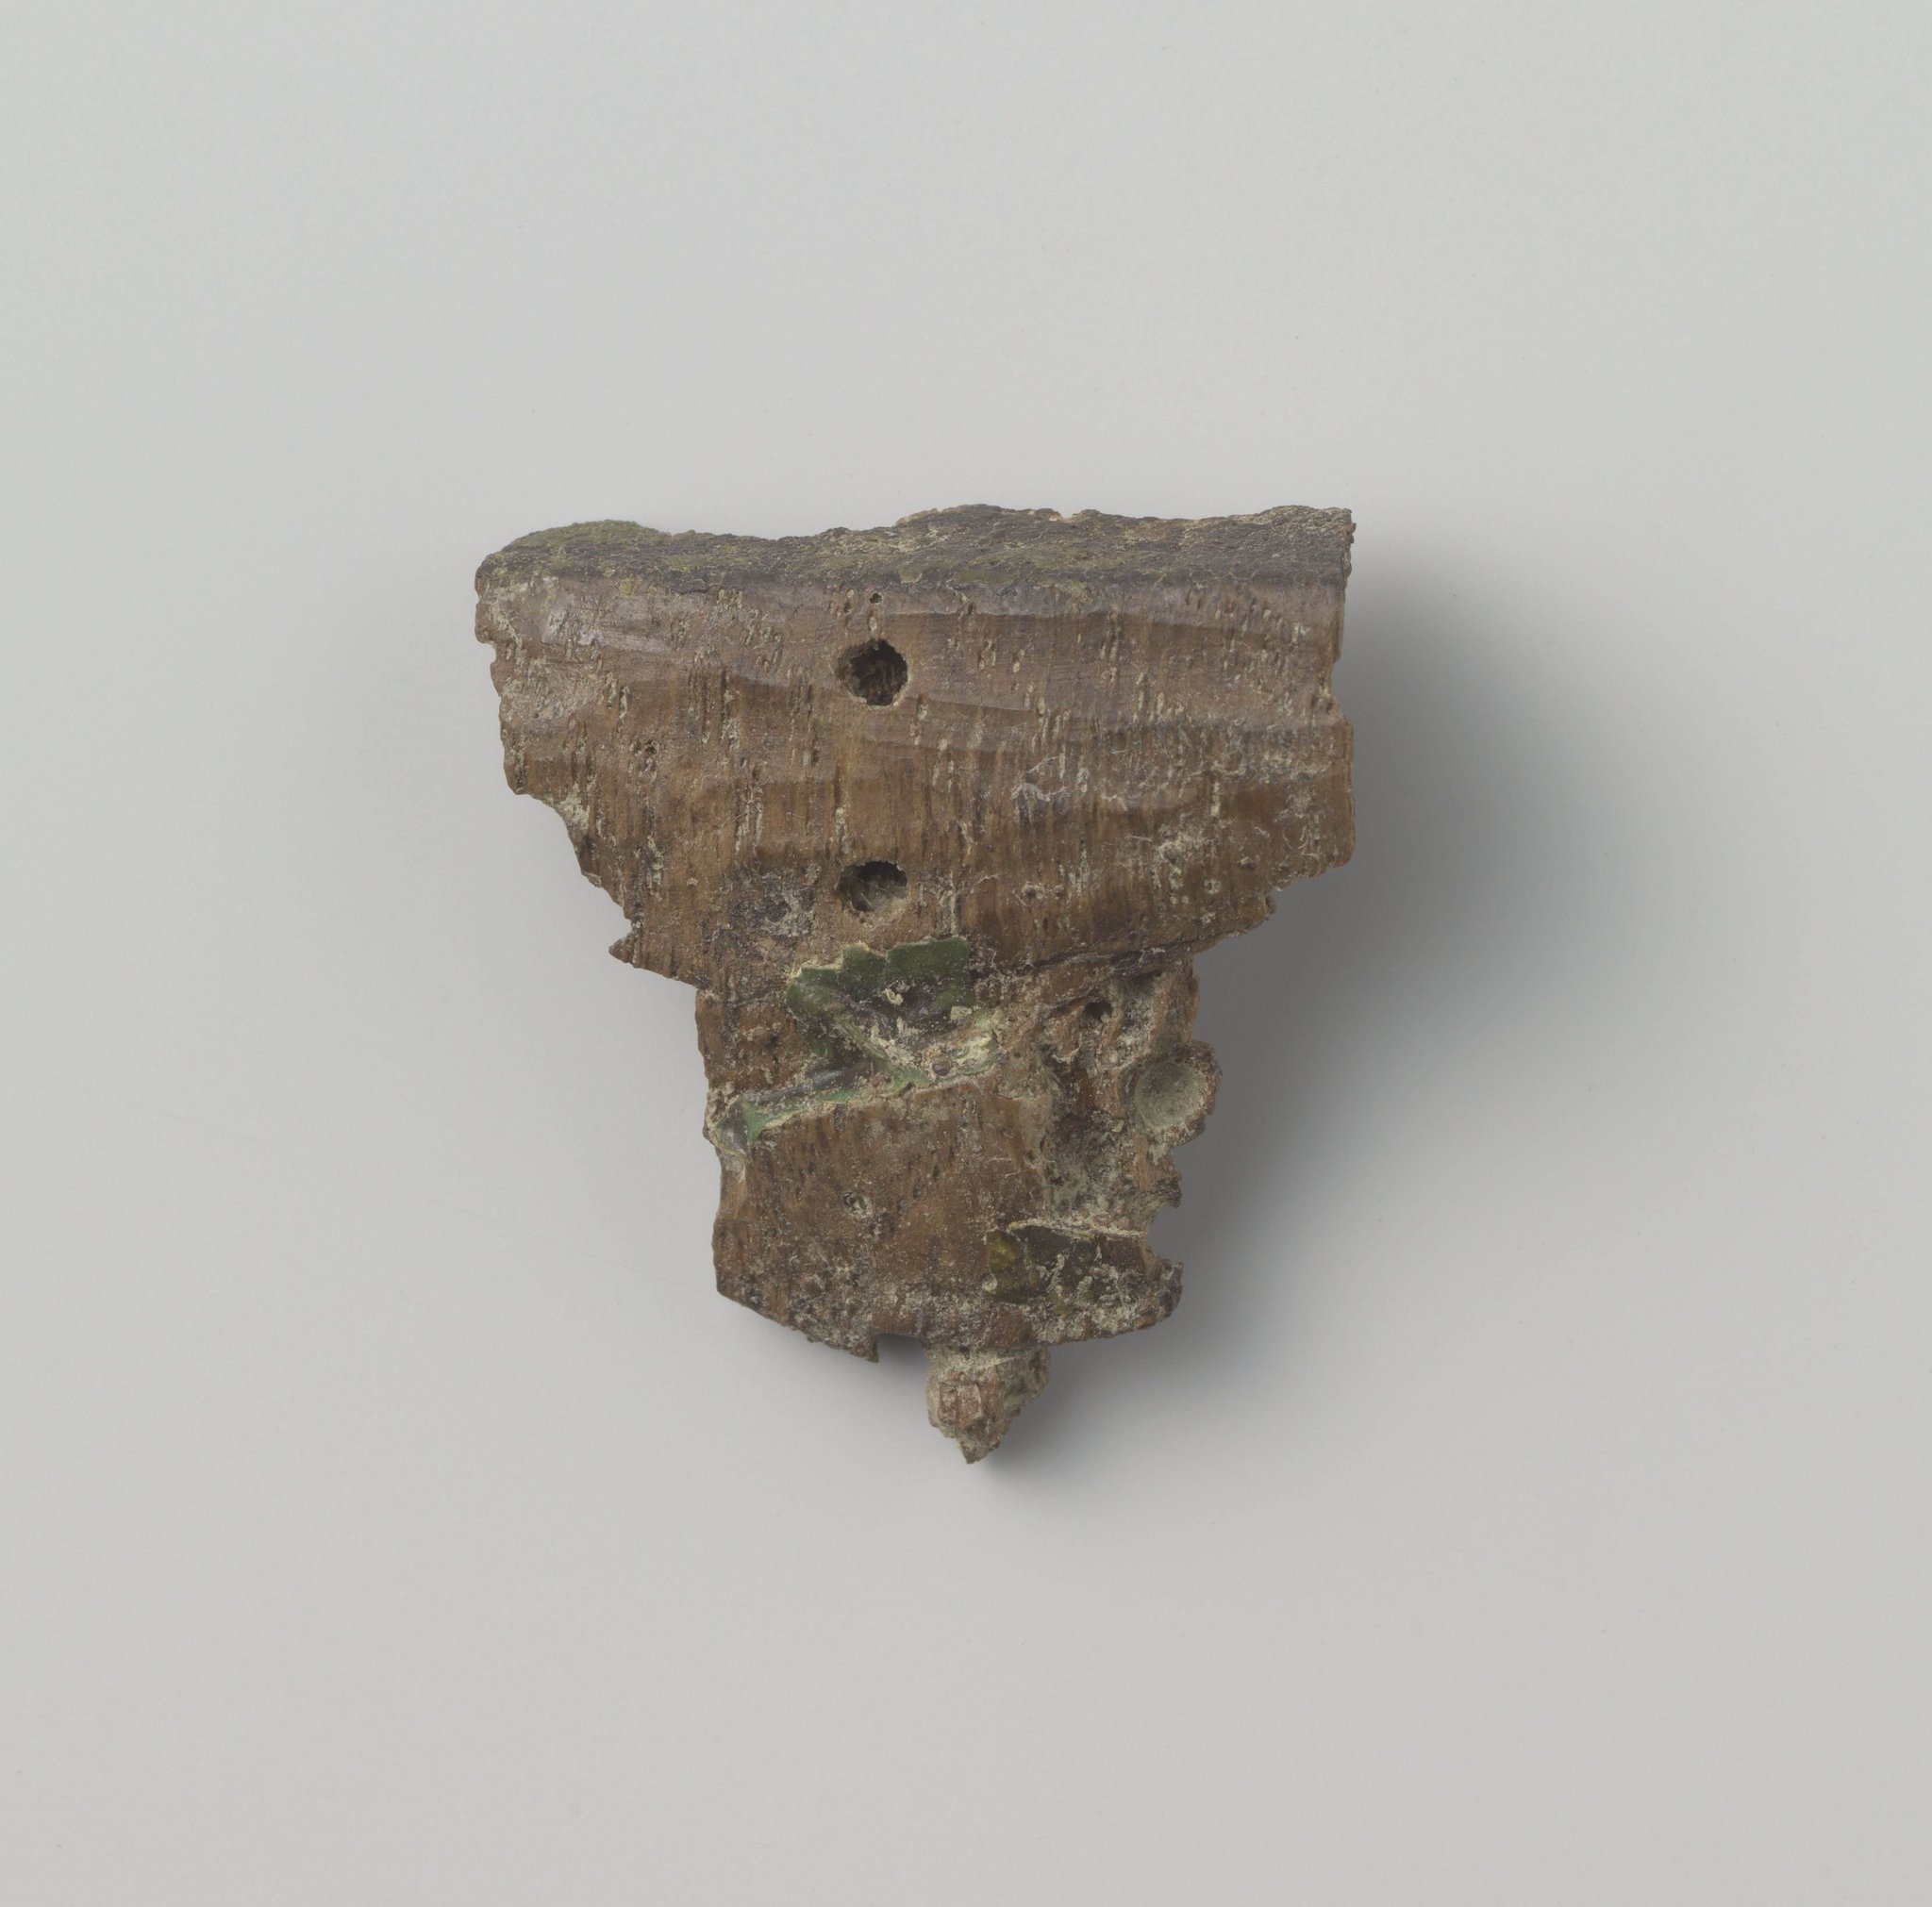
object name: fragment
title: Fragment; (mogelijk) behorend tot het retabel van Soest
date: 1475-1499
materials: wood